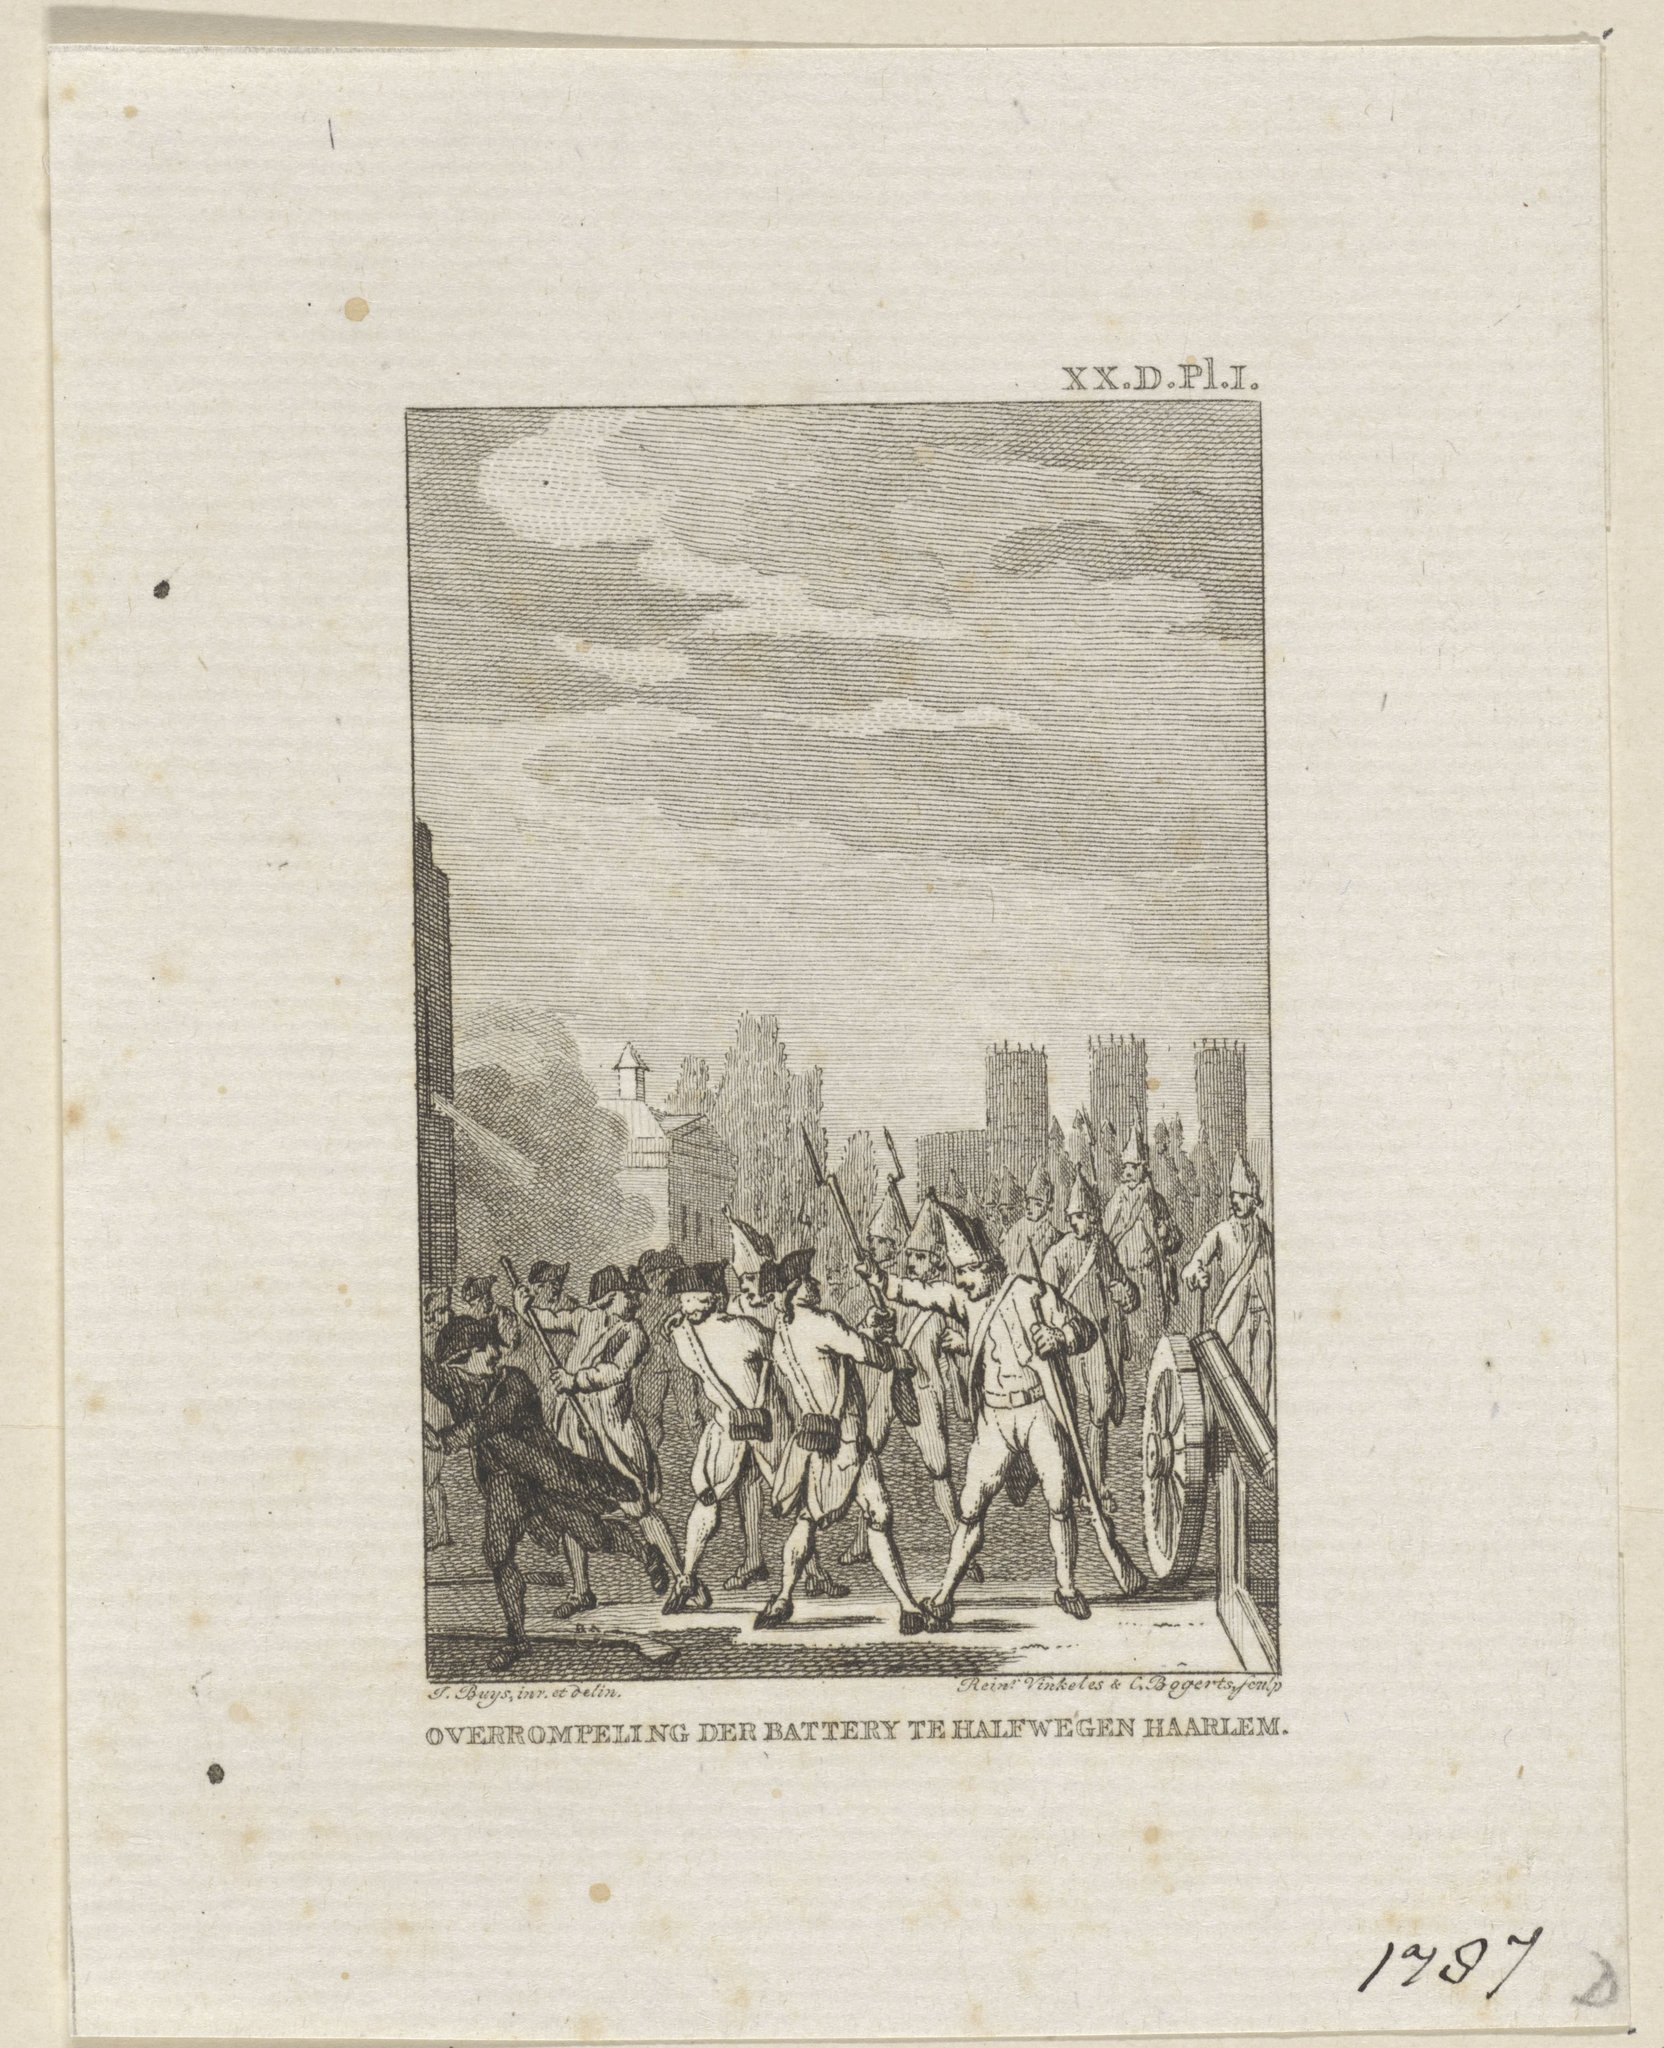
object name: history print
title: Gevecht bij Halfweg, 1787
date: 1783-1795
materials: paper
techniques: etching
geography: amsterdam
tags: surprise attack (stratagem)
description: Illustratie voor: J. Fokke. Geschiedenissen der Vereenigde Nederlanden voor de vaderlandsche jeugd. Amsterdam: Johannes Allart, 1783-1795, 25 delen. deel XX pl. I.